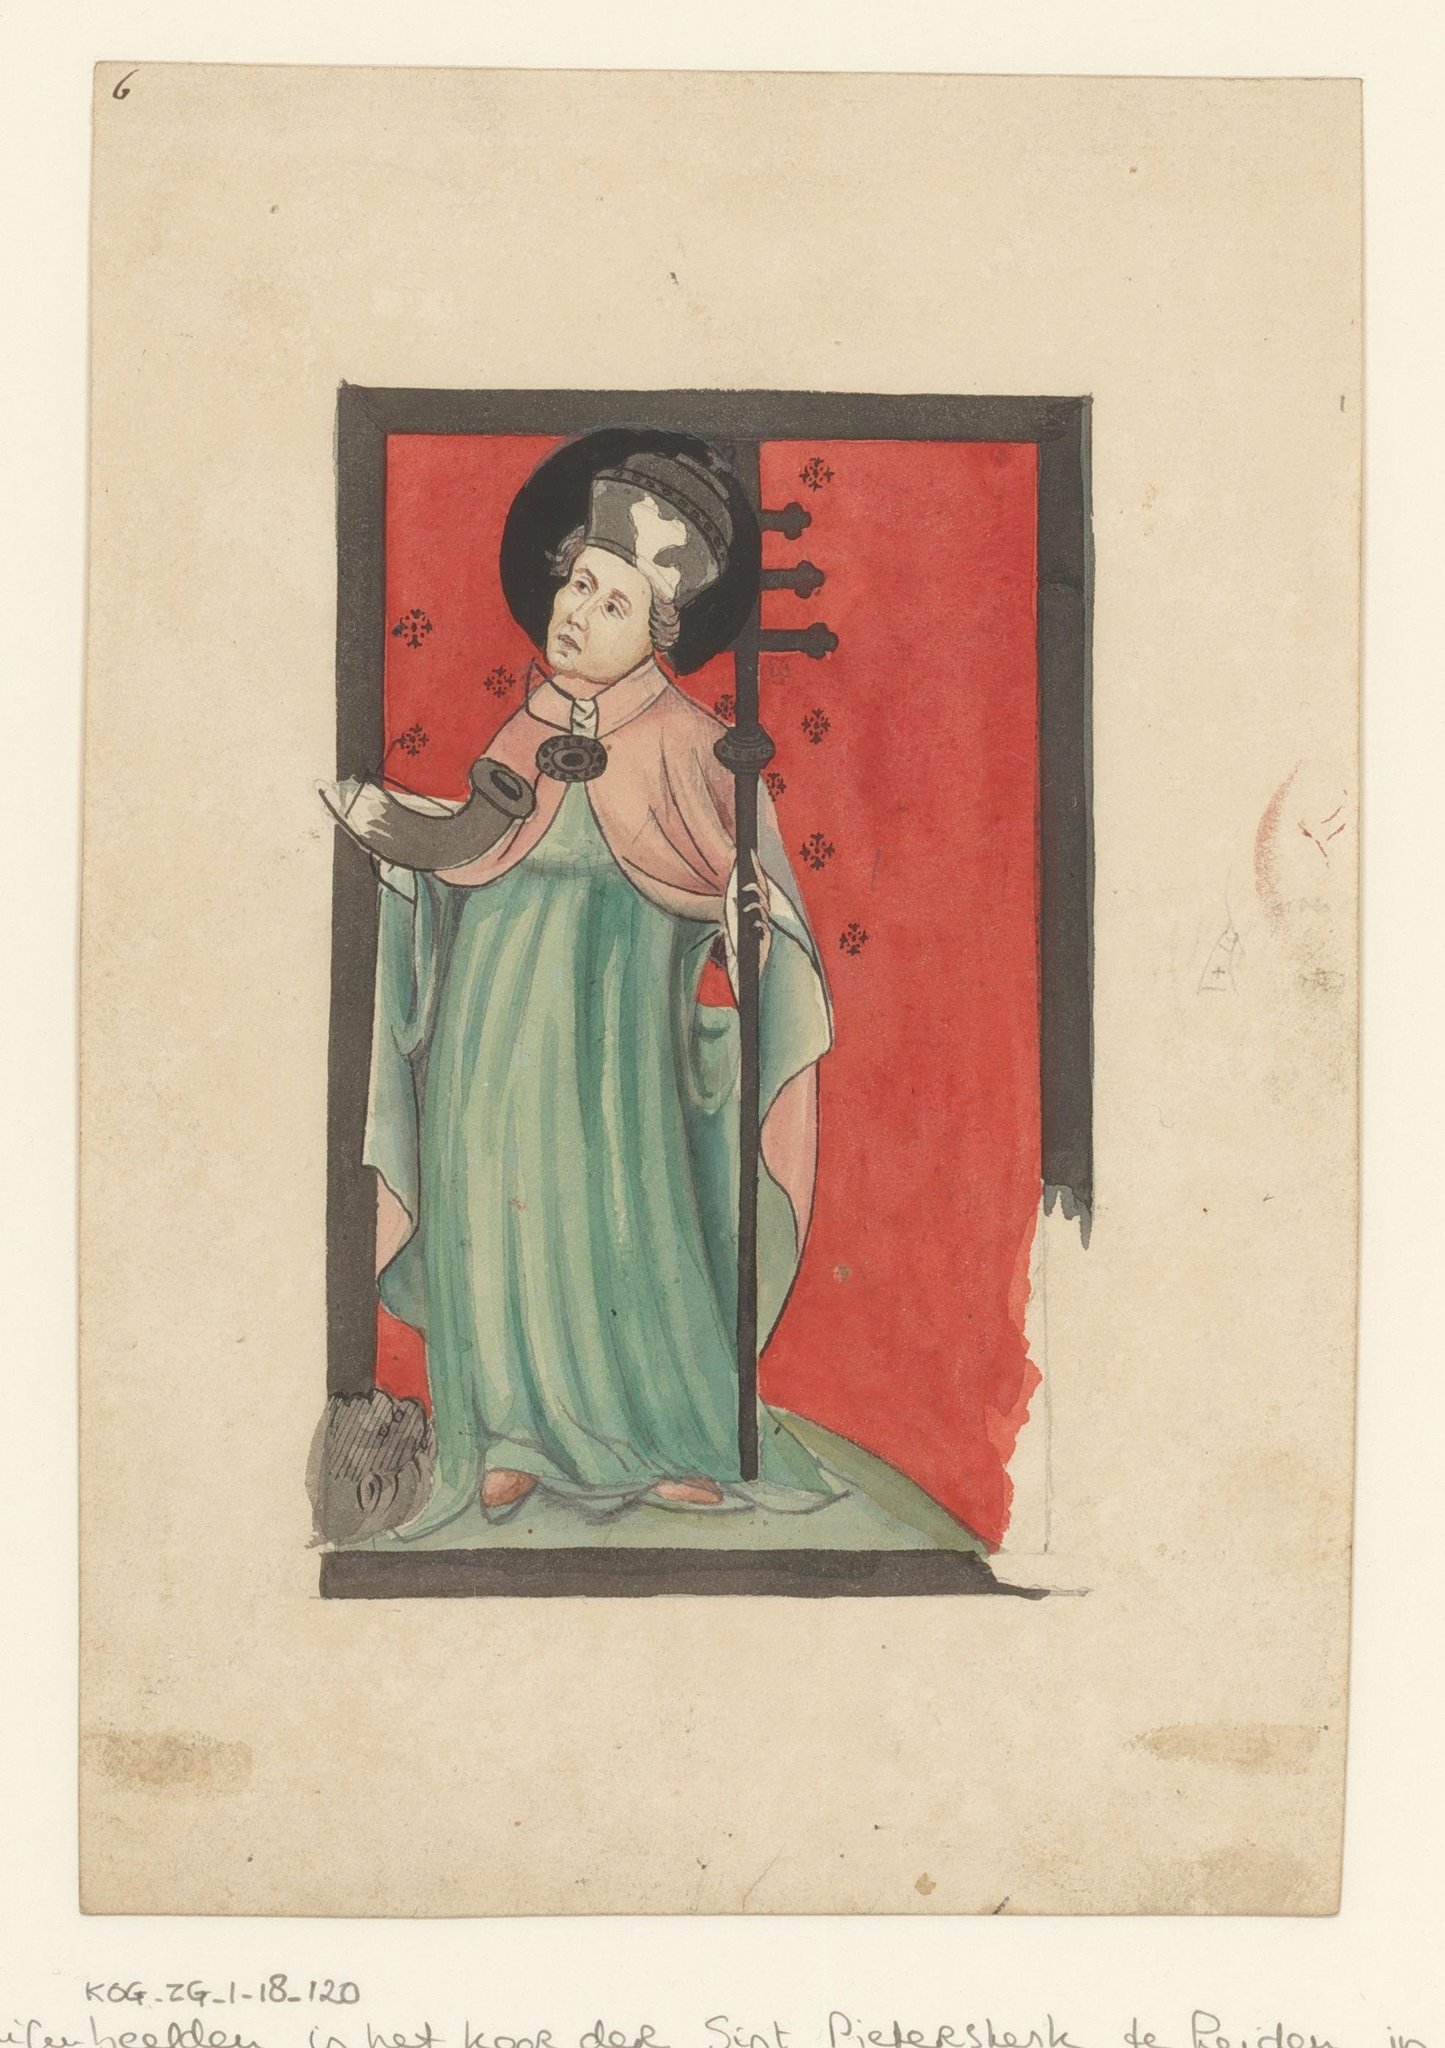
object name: drawing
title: Paus Cornelius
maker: tiemen hooiberg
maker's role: painter, print maker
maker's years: 1809-1897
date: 1844-1846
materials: ink, paper, watercolor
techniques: brush, pen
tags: saints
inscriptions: stamp, collector's mark: Lugt 1641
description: Paus Cornelius met pauselijke staf en drinkhoorn. Linksboven genummerd: 6. Onderwerpsrubrieken binnen de Atlas Zeden en Gewoonten: Schoone kunsten, Muur- en gewelfschilderingen.